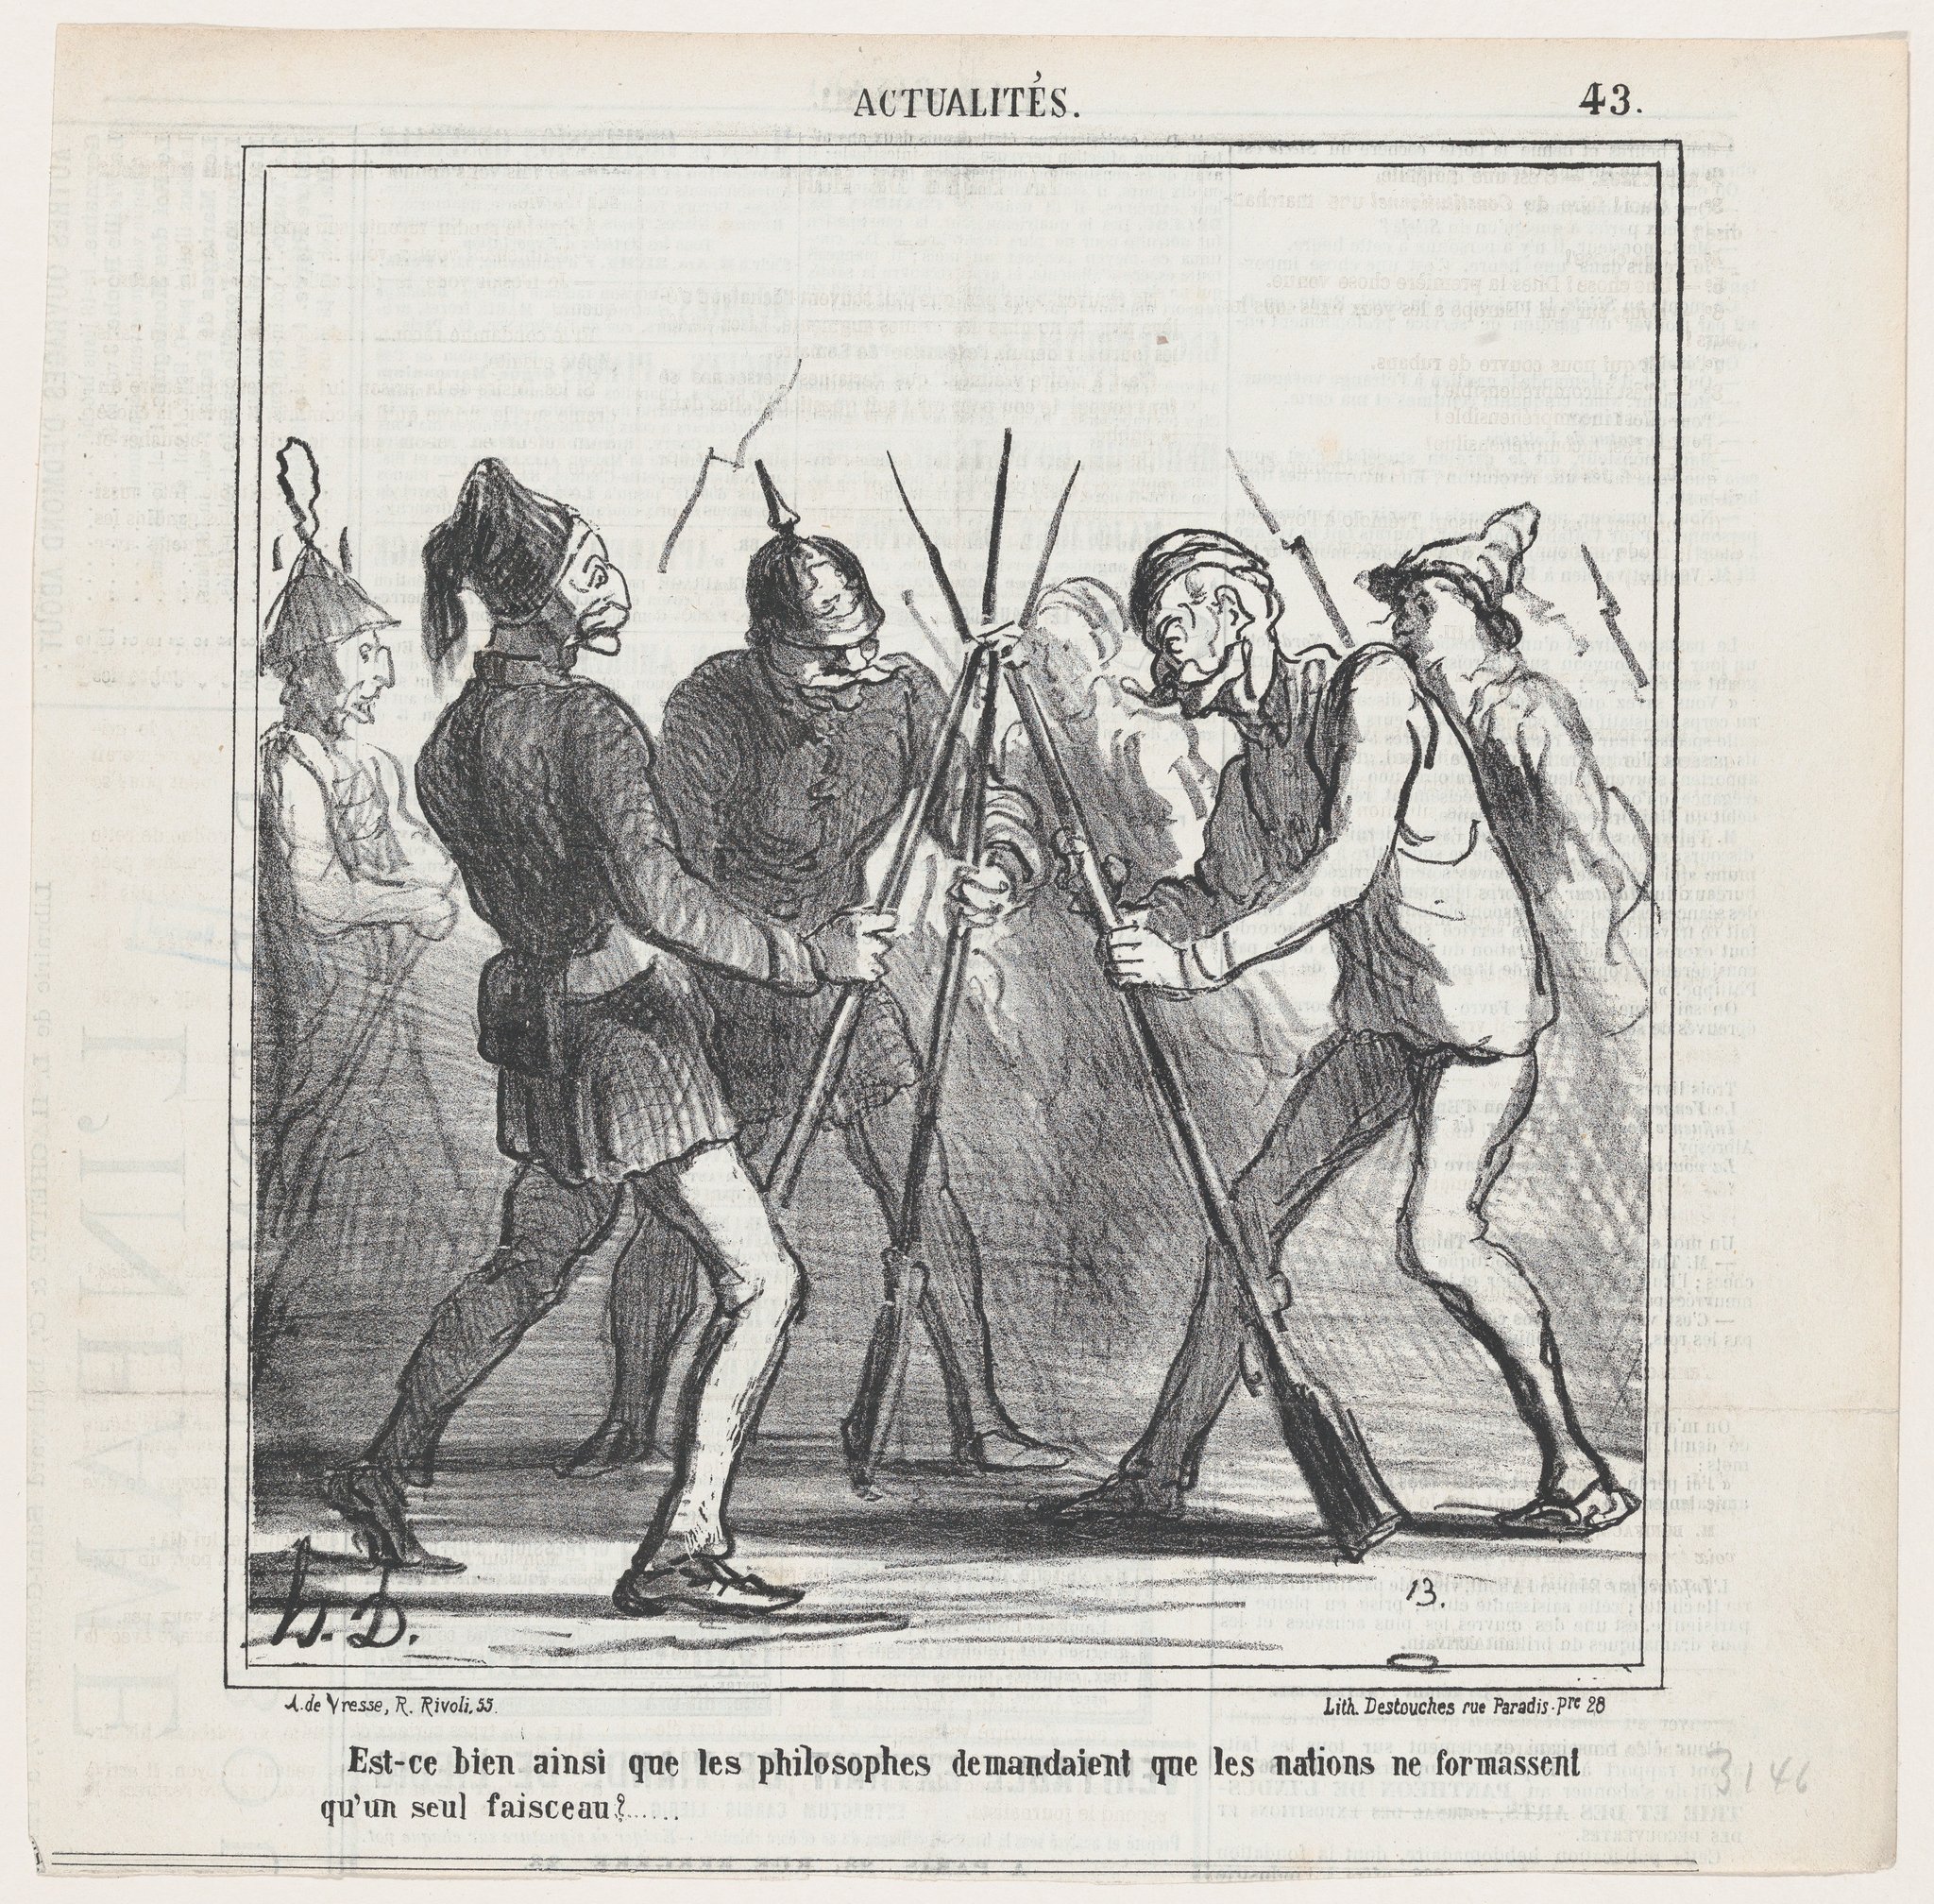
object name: print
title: Is this really what the philosophers were thinking of when they asked that the nations should form a mutual bundle?, from 'News of the day,' published in "Le Charivari"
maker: honoré daumier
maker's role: artist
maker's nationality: french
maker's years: 1808-1879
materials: paper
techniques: lithograph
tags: satire,men